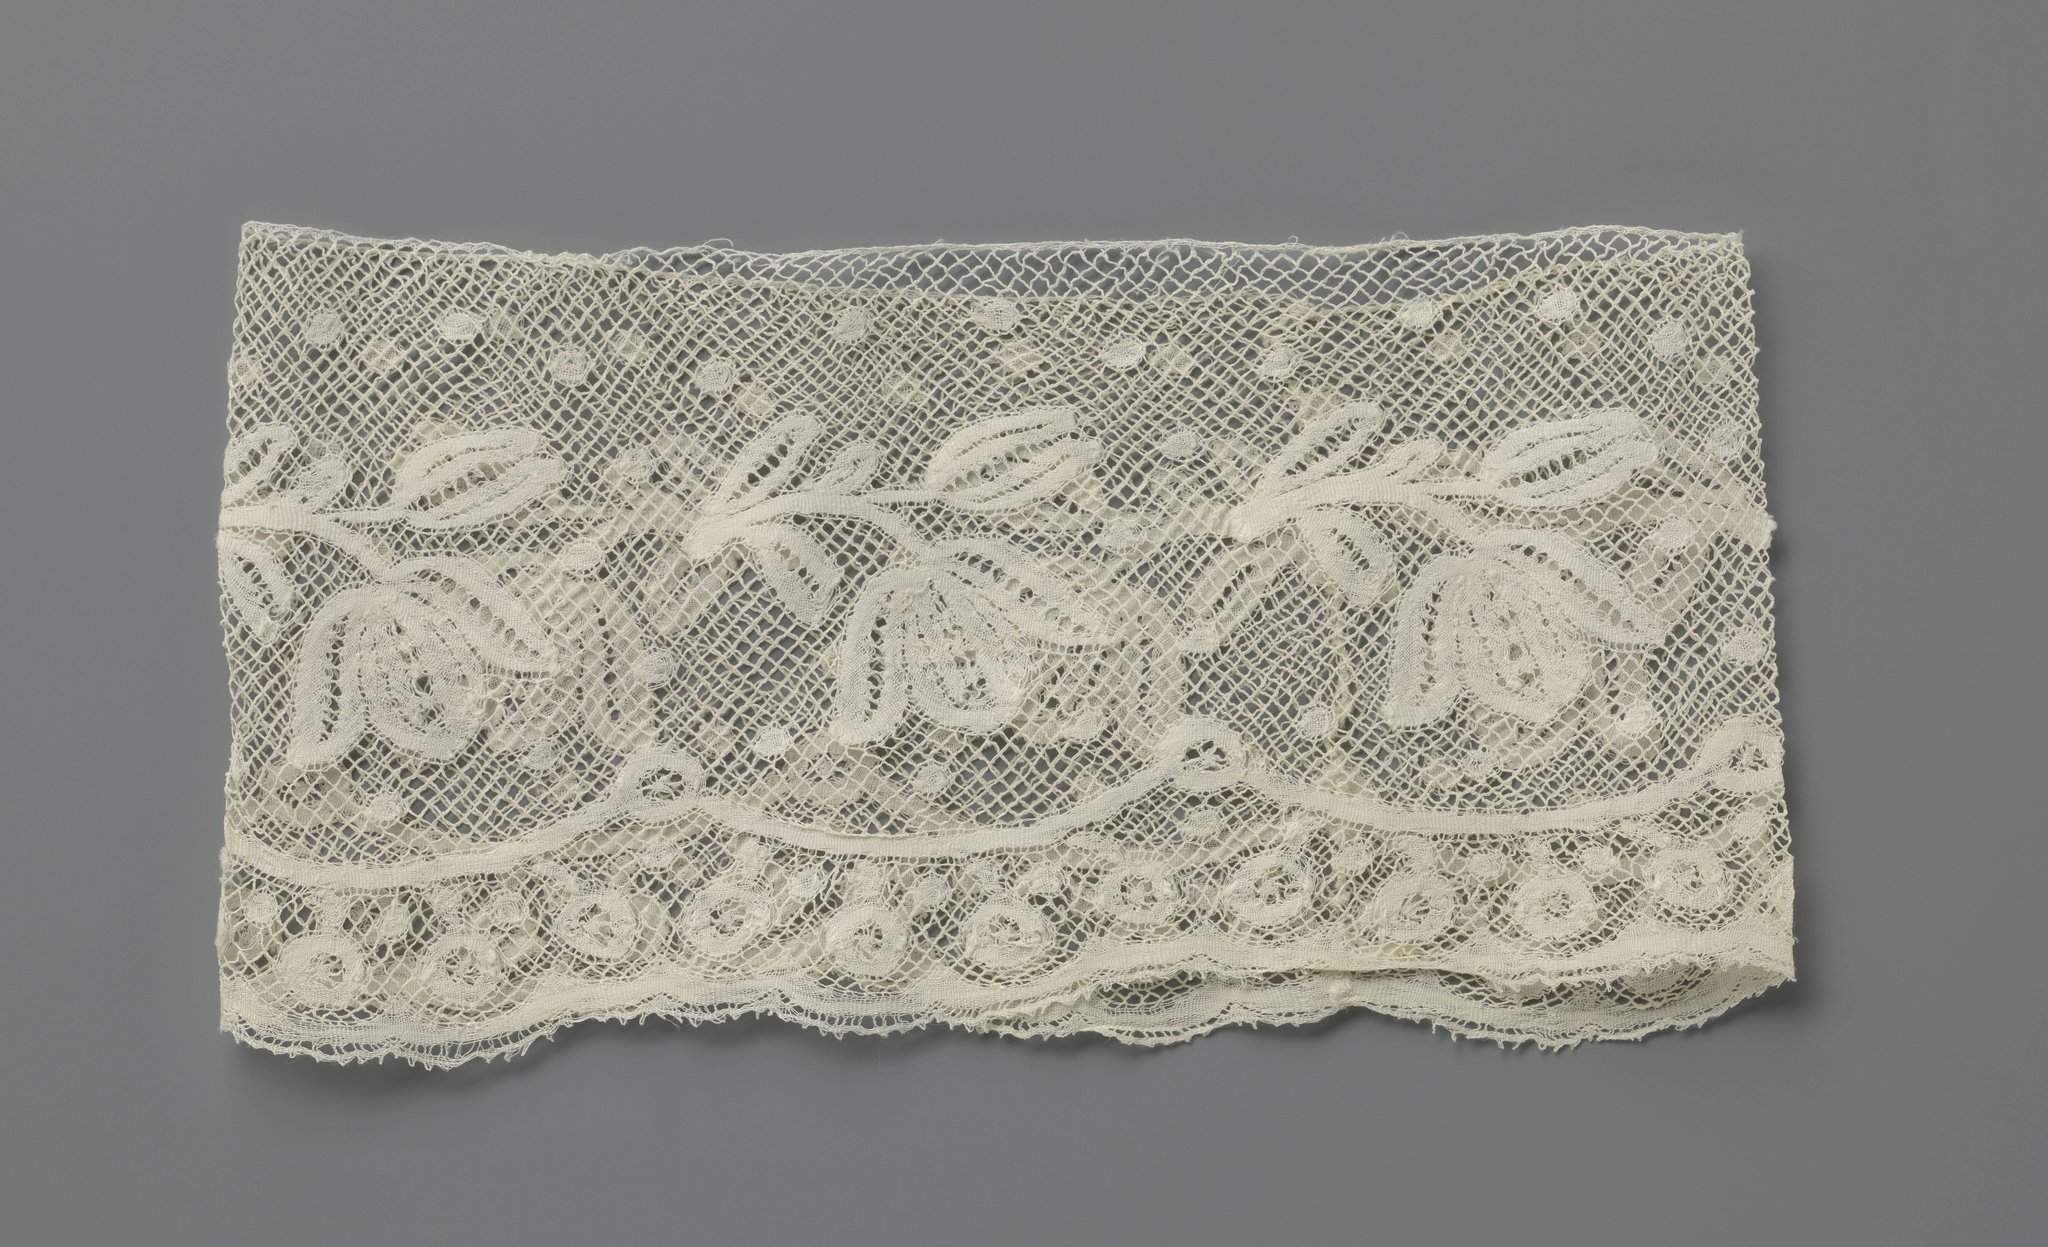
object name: cuff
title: Manchet van kloskant met hangende tulp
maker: Anonymous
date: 1900-1909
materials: linen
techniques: lace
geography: netherlands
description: Manchet van naturelkleurige kloskant: Valenciennes-kant. Op een grove traliegrond (vierkante tralie), dat met 'pailletten' is bezaaid, staat een lopend patroon. Eenzijdig gerichte hangende tulpen staan los boven gestrekte schulpen van een guirlande met afhangende bessen.